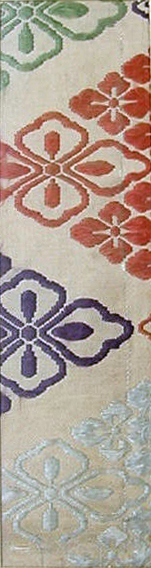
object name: piece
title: Textile with Floral Lozenges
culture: japanese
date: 1615-1868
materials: silk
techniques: brocade, weave